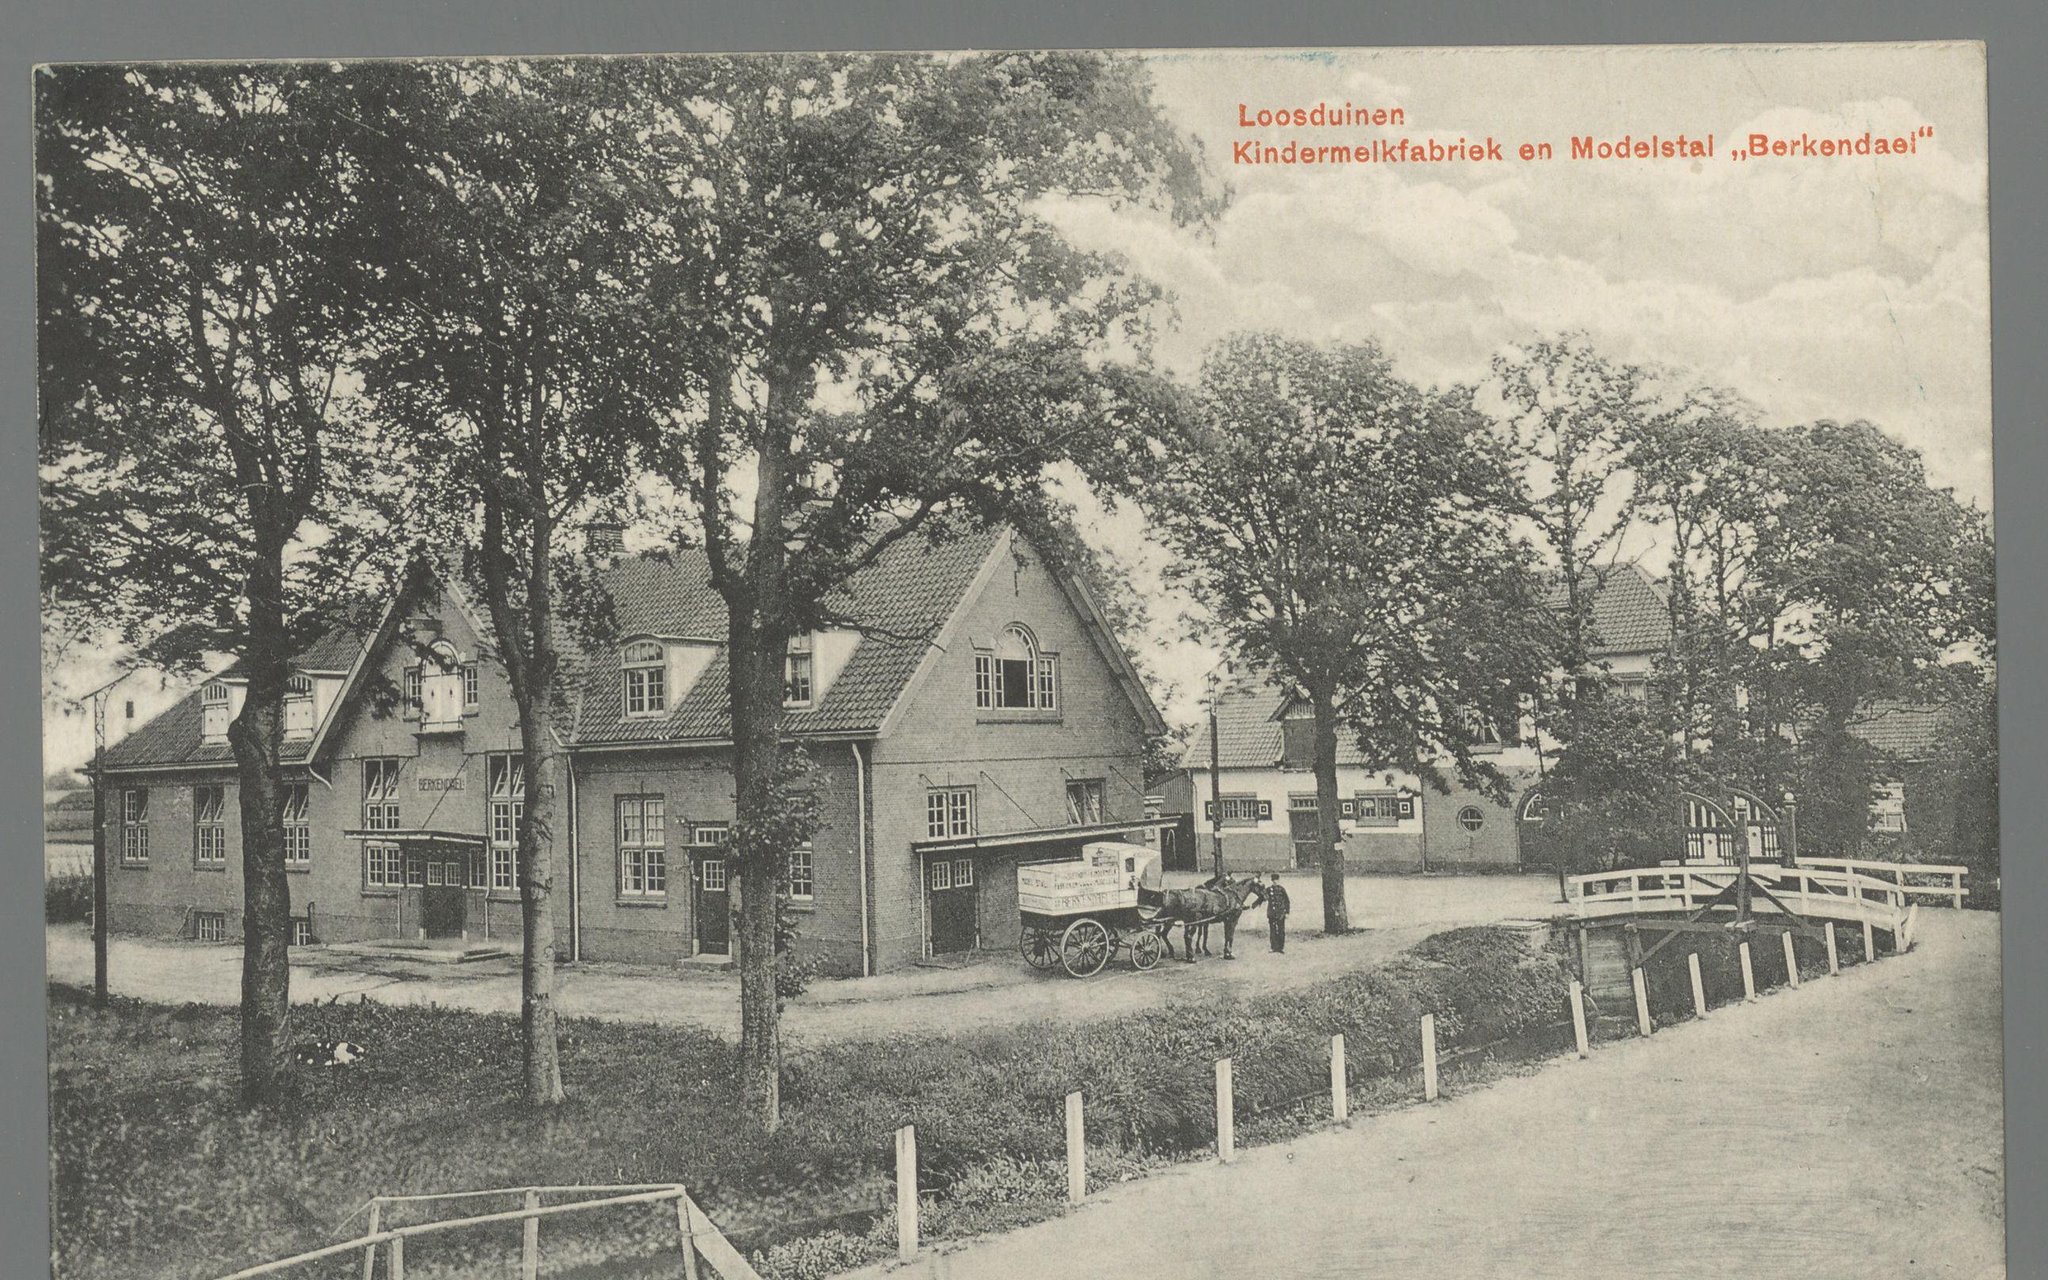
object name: photomechanical print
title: Loosduinen. Kindermelkfabriek en modelstal "Berkendael"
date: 1905-1940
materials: cardboard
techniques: photograph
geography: loosduinen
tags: barn, milk, farm (building)